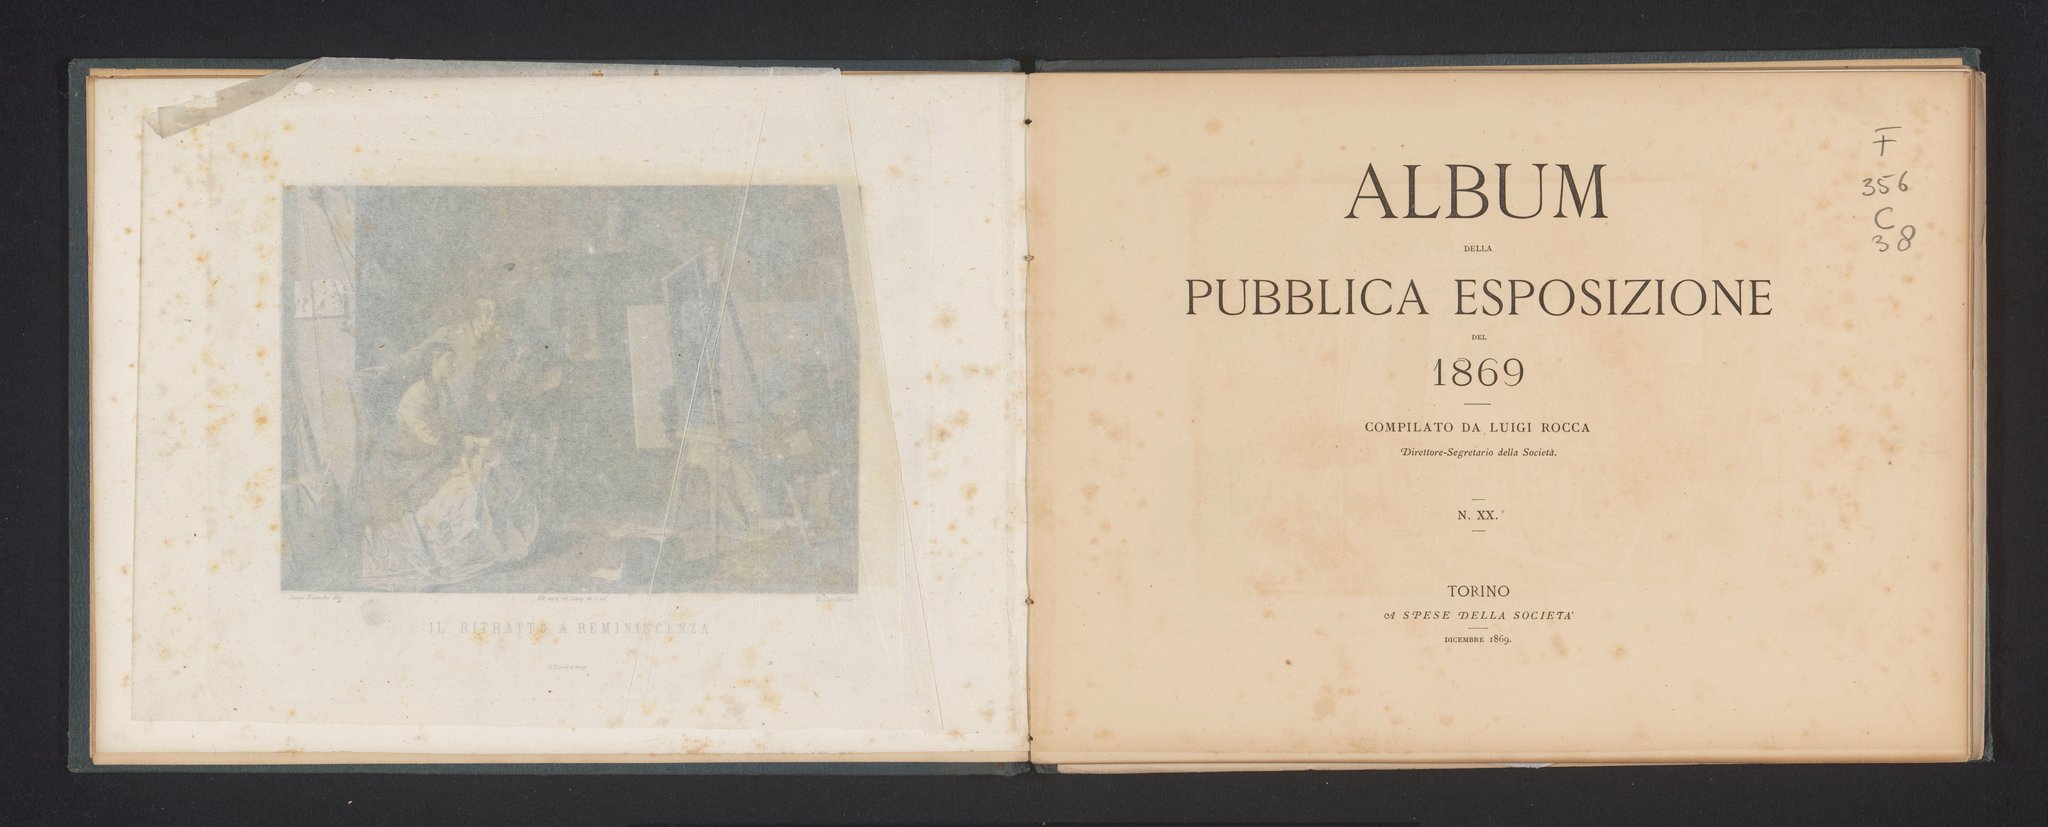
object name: book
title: Album della pubblica esposizione del 1869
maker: luigi rocca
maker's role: auteur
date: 1869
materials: cardboard, linen, paper, photographic support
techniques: albumen print, engraving, printing